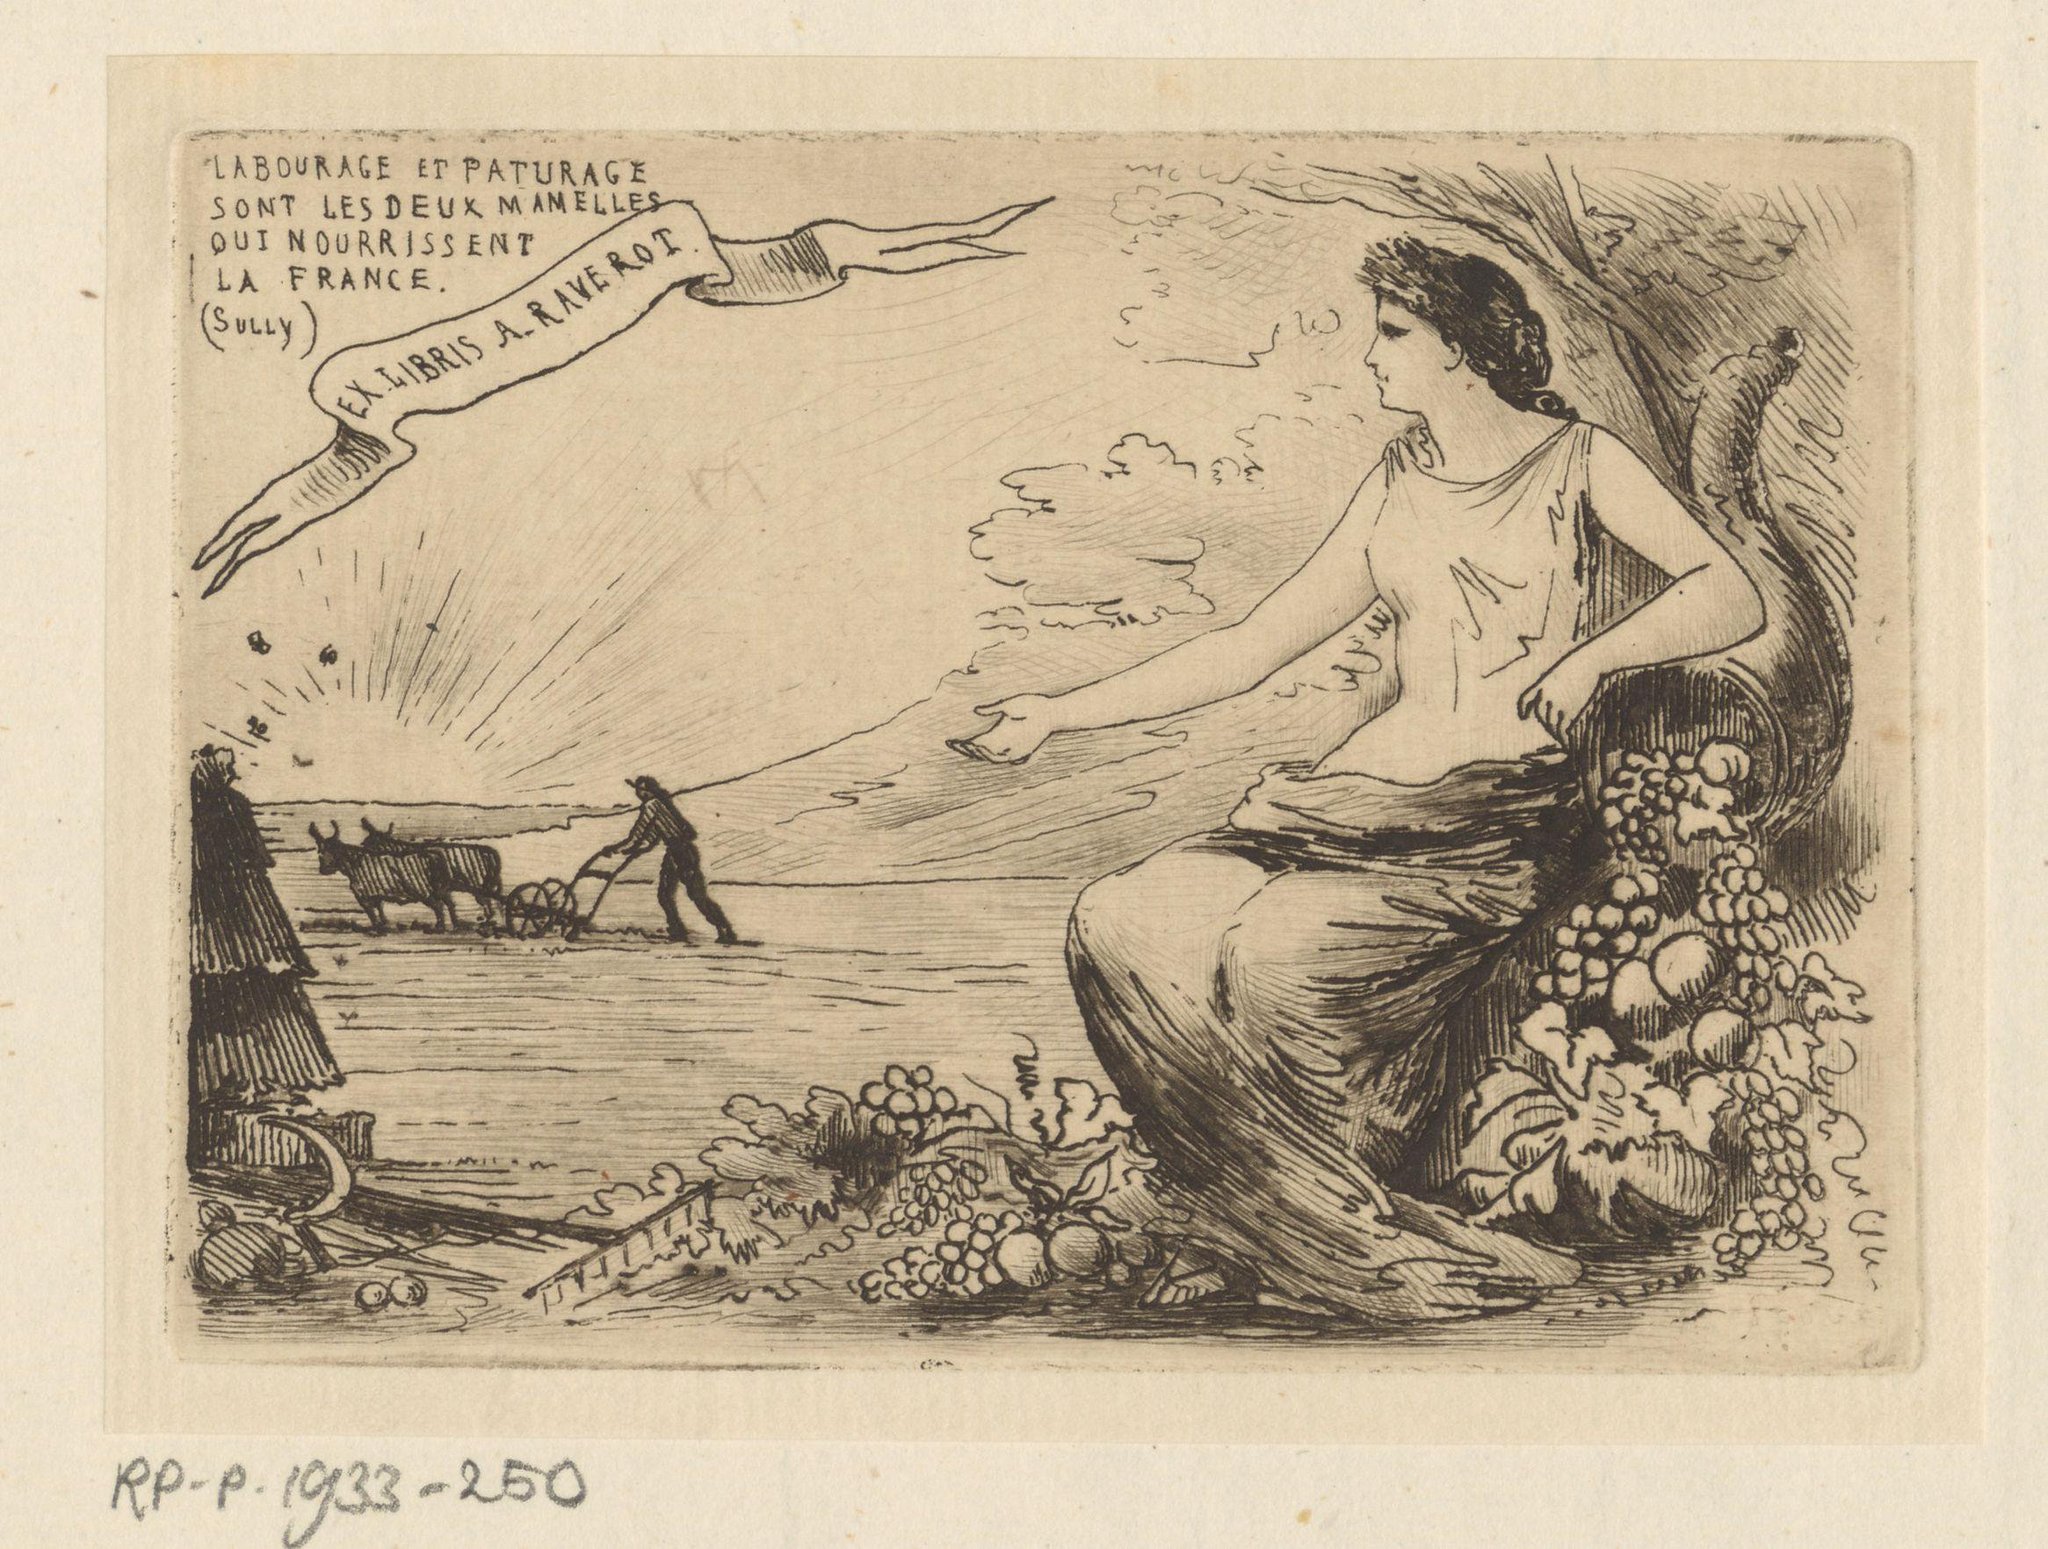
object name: bookplate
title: Labourage et paturage sont les deux (...)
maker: Anonymous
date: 1880-1933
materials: paper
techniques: drypoint, etching, intaglio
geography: france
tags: 'cornucopia', horn of plenty, sitting figure - aa - female human figure, ploughing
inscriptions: collector's mark: Lugt 2760